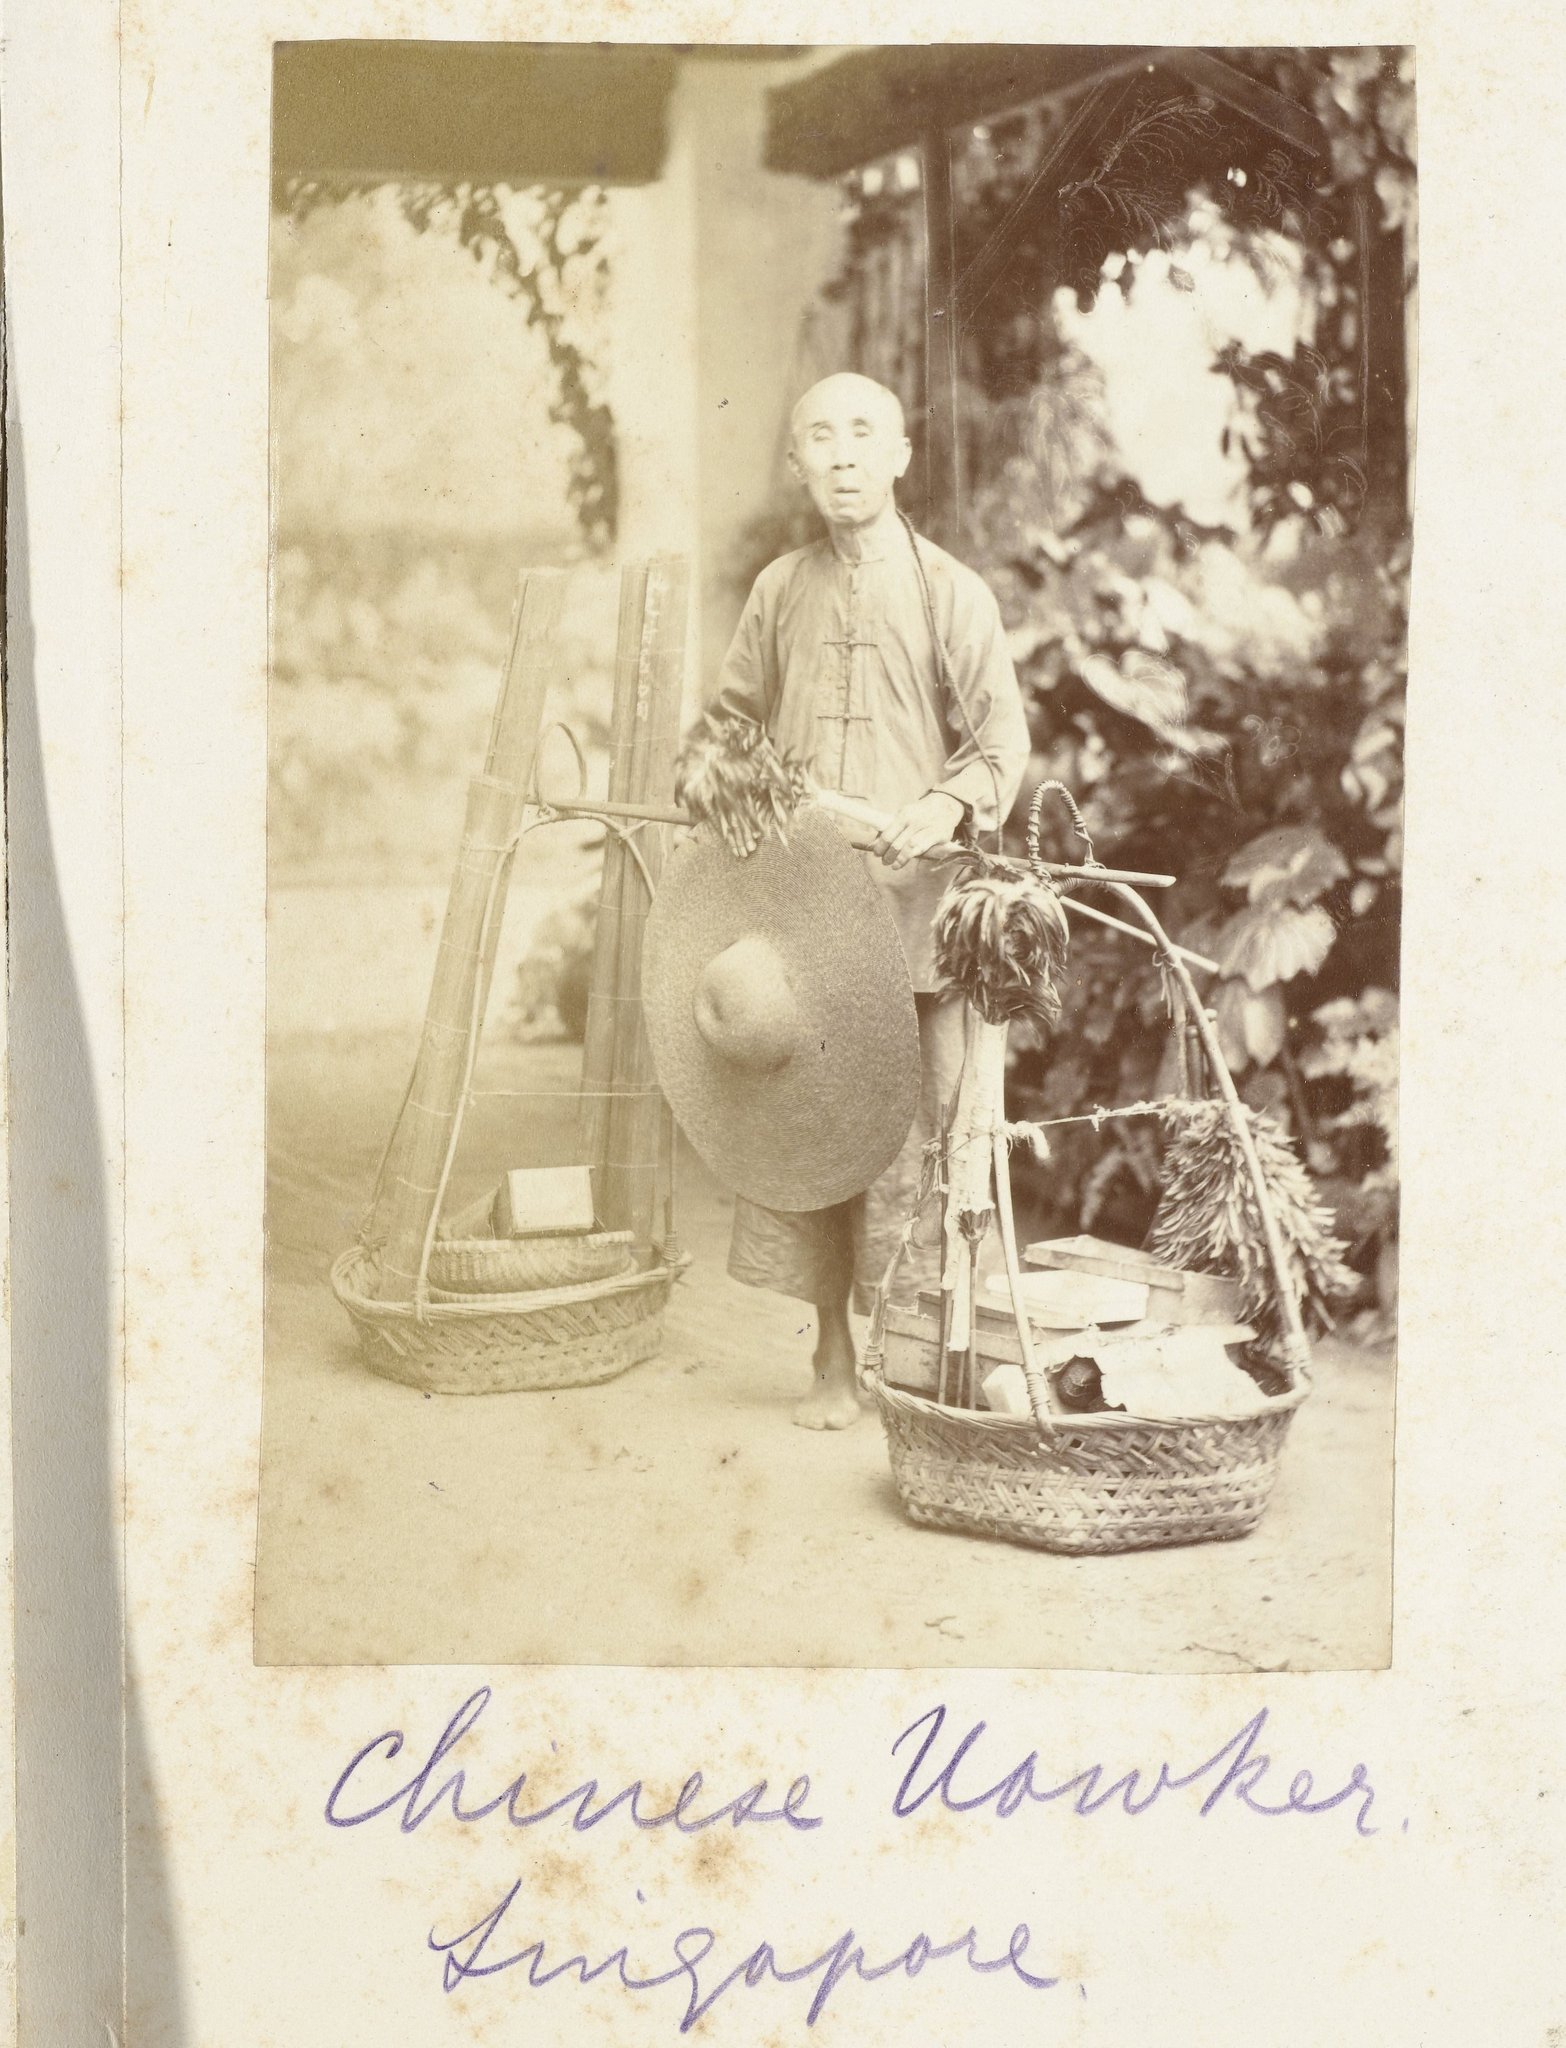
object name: photograph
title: Chinese straatvekoper met manden die over de schouder hangen vol met verkoopwaar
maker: Anonymous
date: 1890-1910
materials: cardboard, paper, photographic support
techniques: gelatin silver print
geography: netherlands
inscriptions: caption: ‘Chinese uawker (?) Singapore’